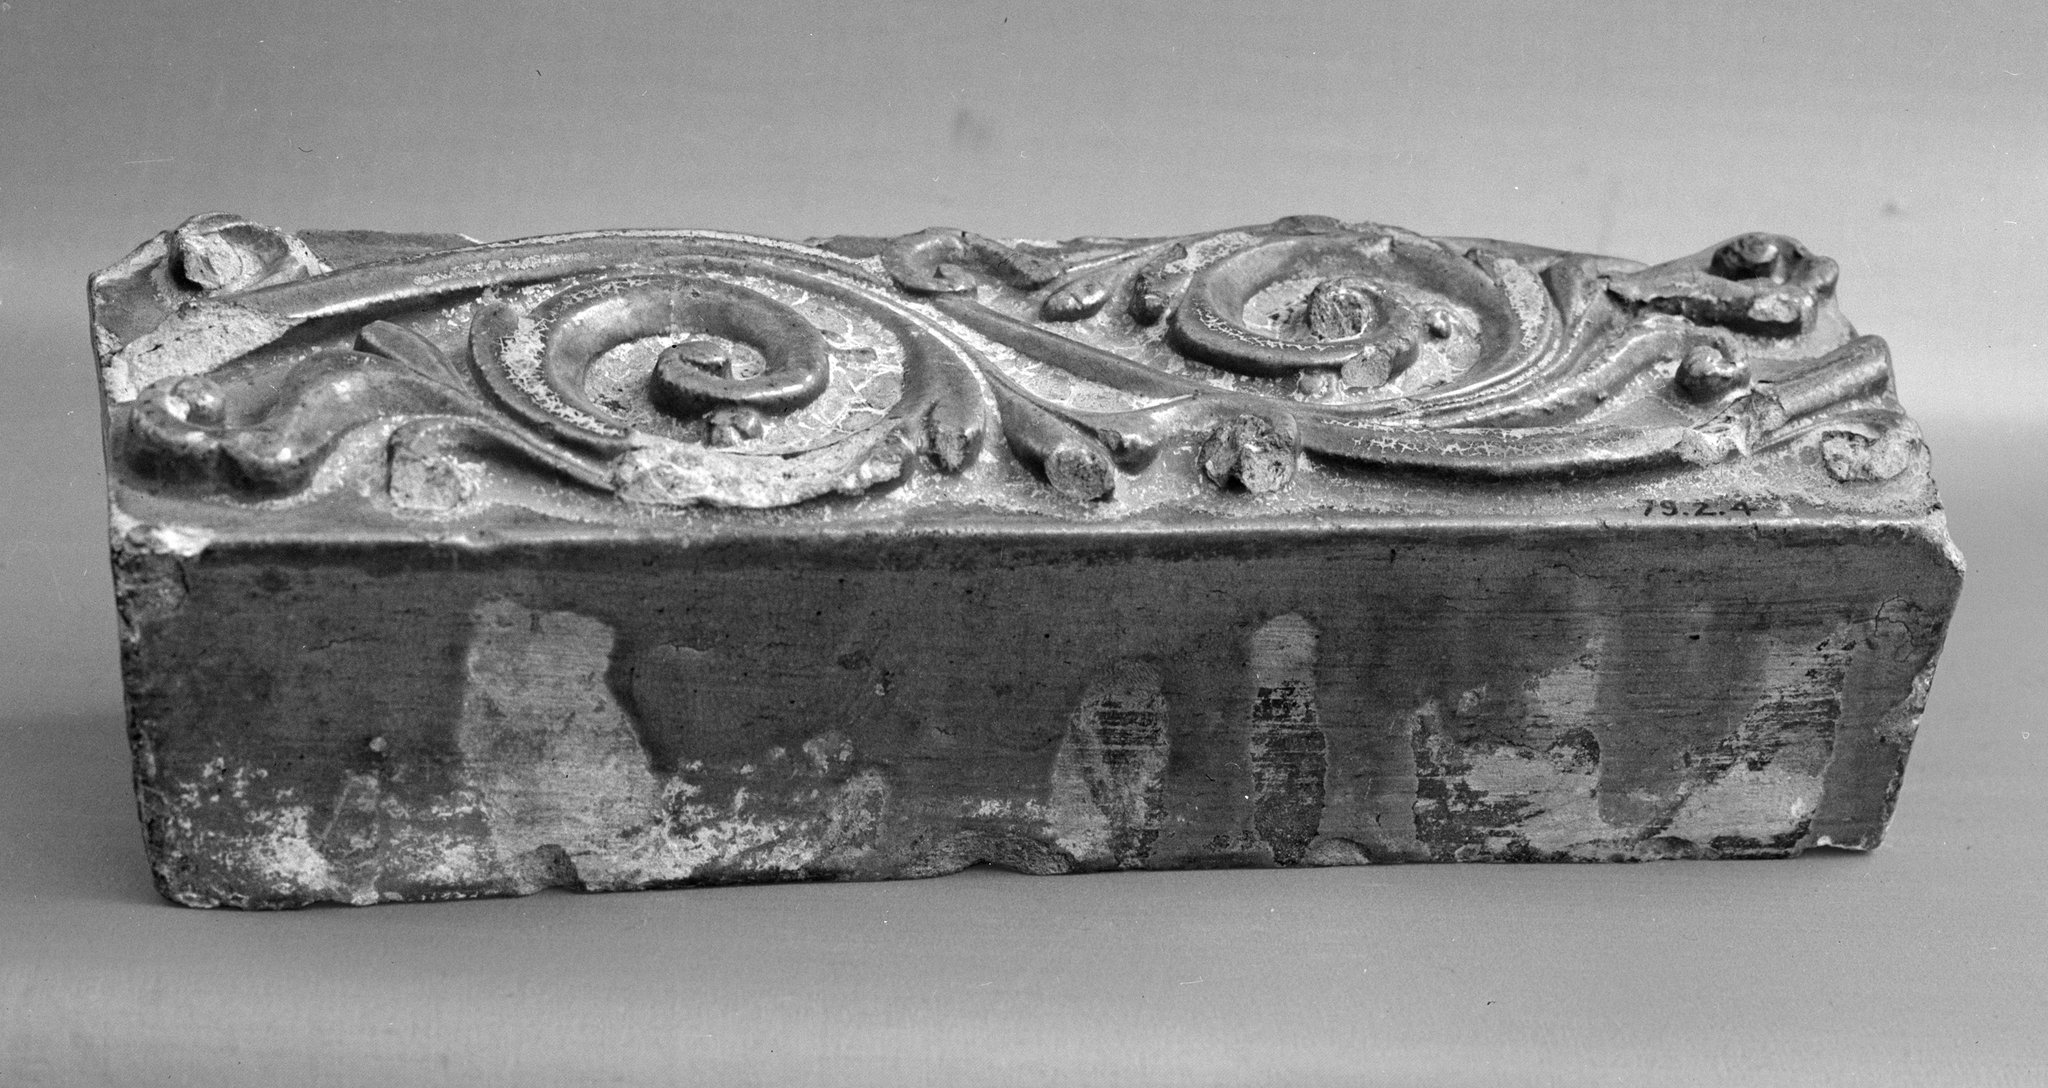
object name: architectural tile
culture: chinese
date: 1401-1500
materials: glaze, stoneware